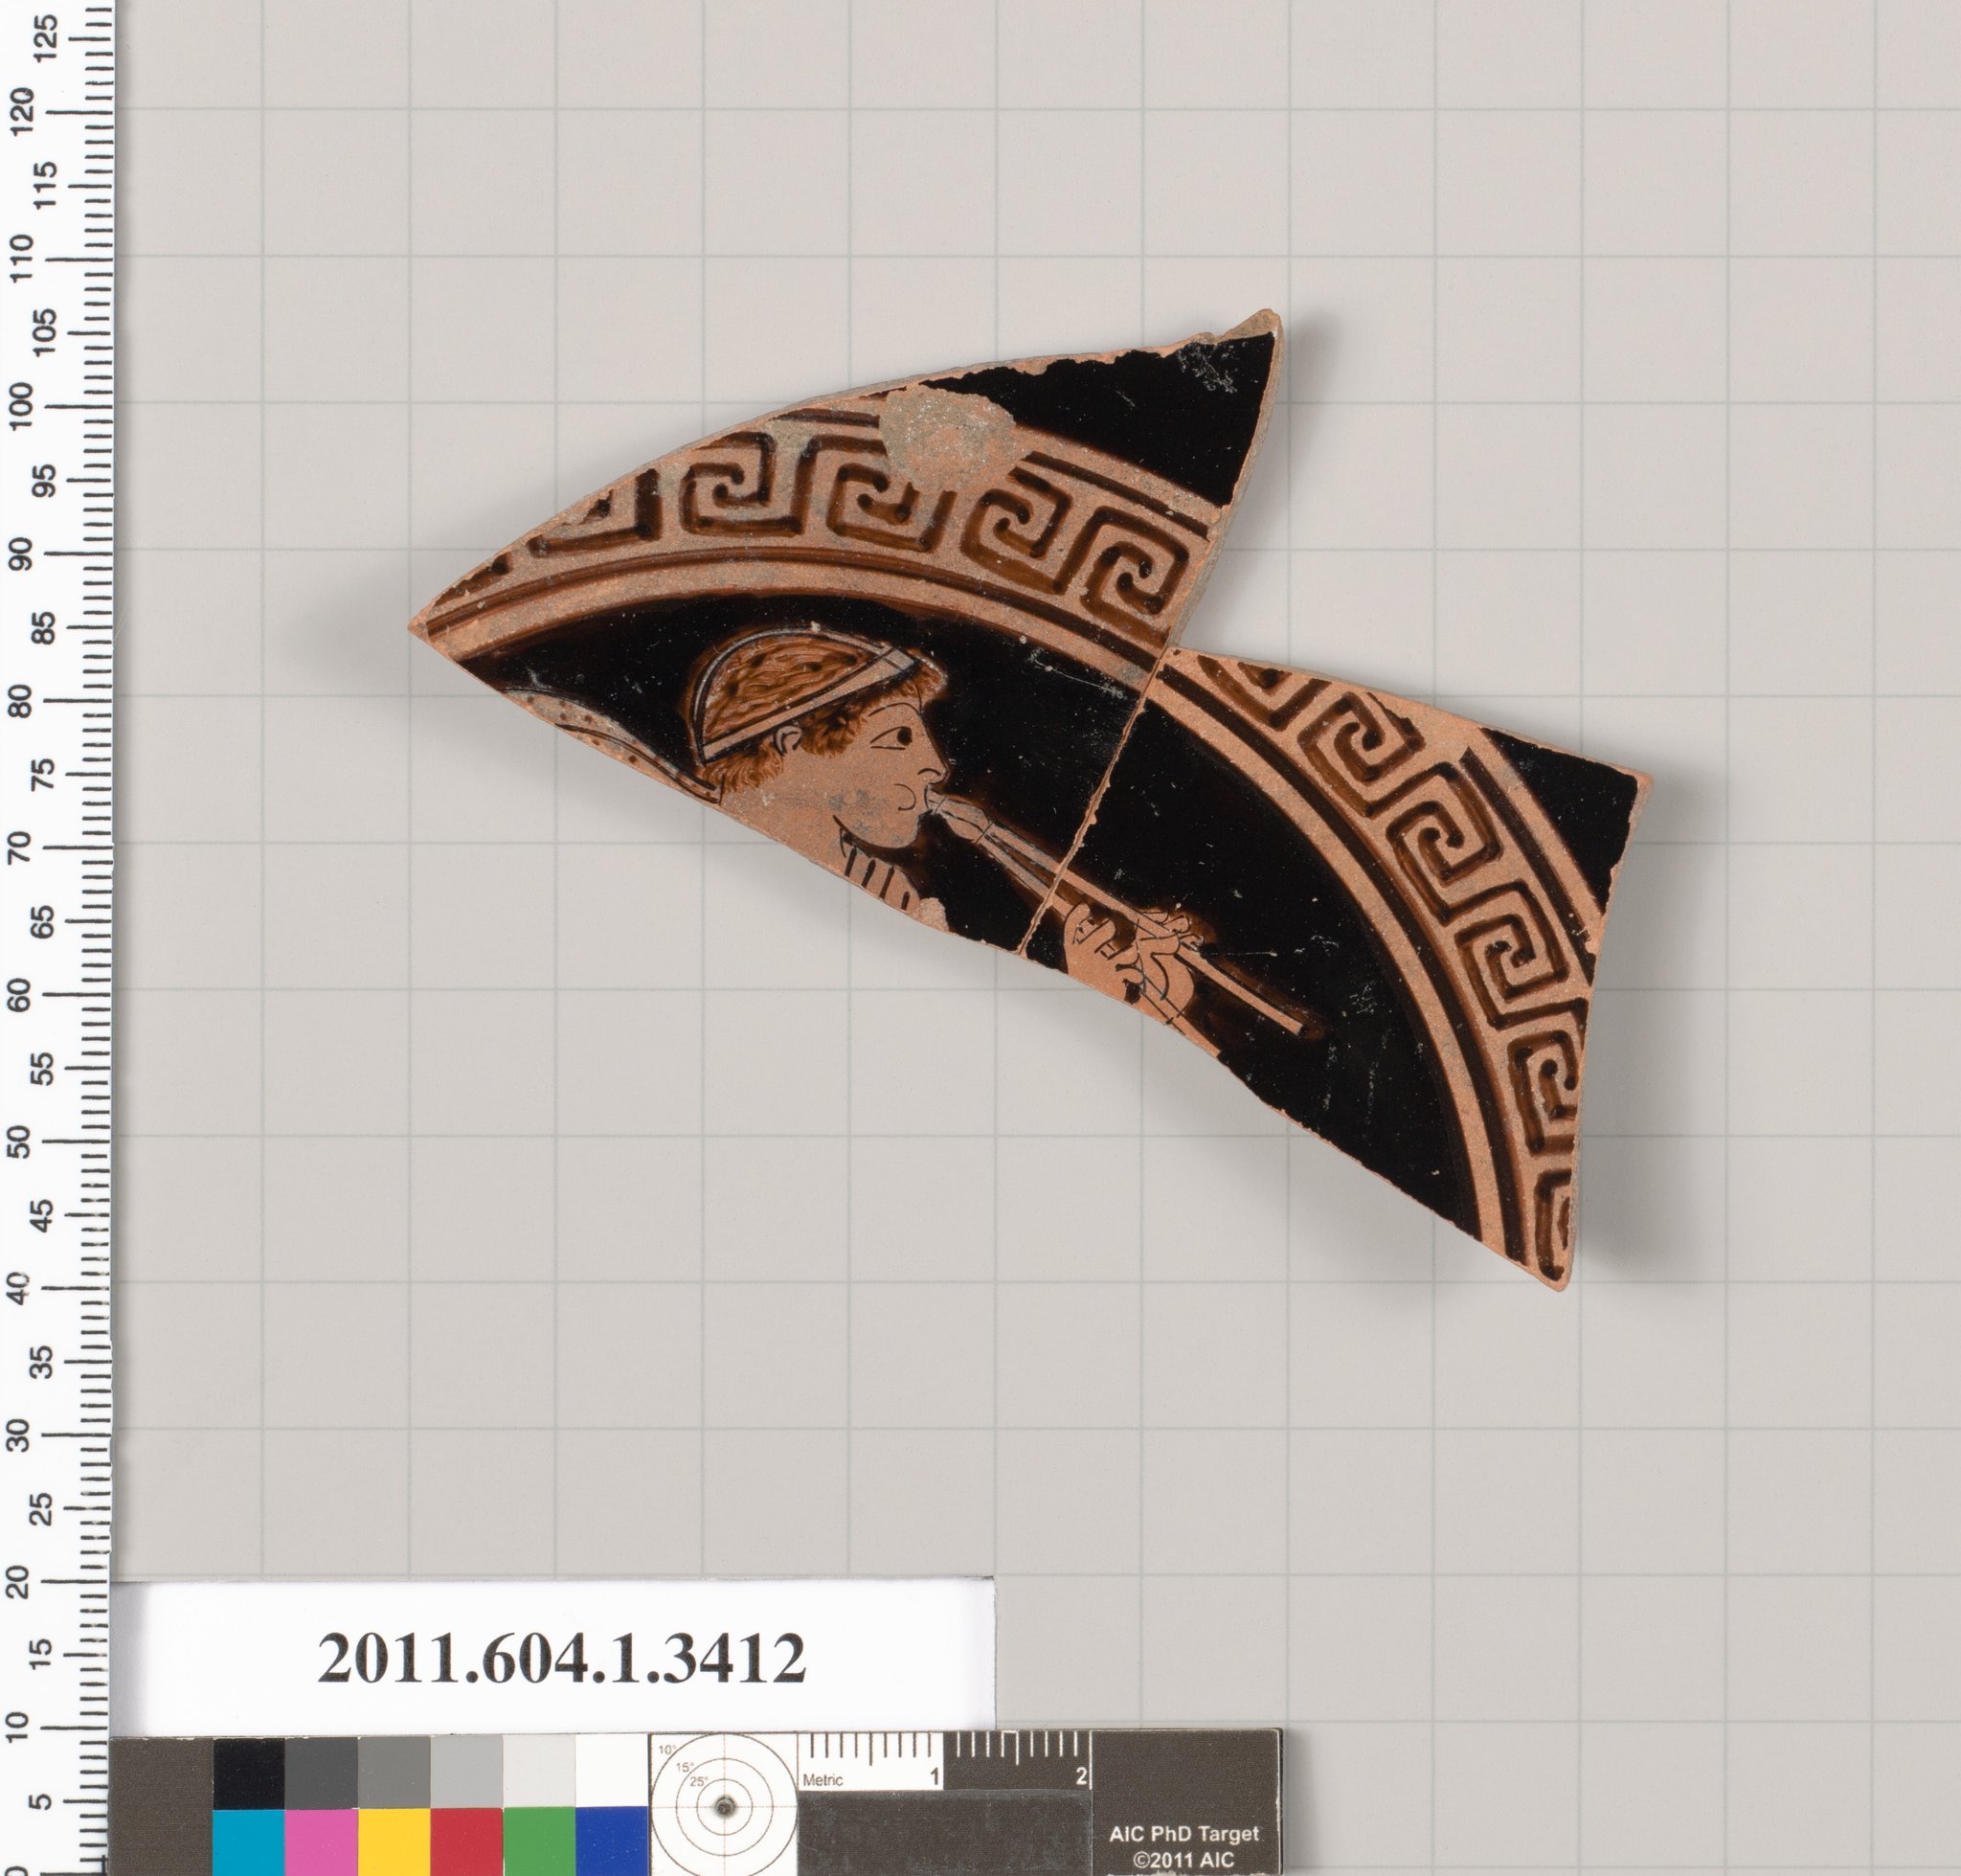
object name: kylix fragment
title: Terracotta fragment of a kylix (drinking cup)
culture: greek, attic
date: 490-470 BCE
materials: terracotta